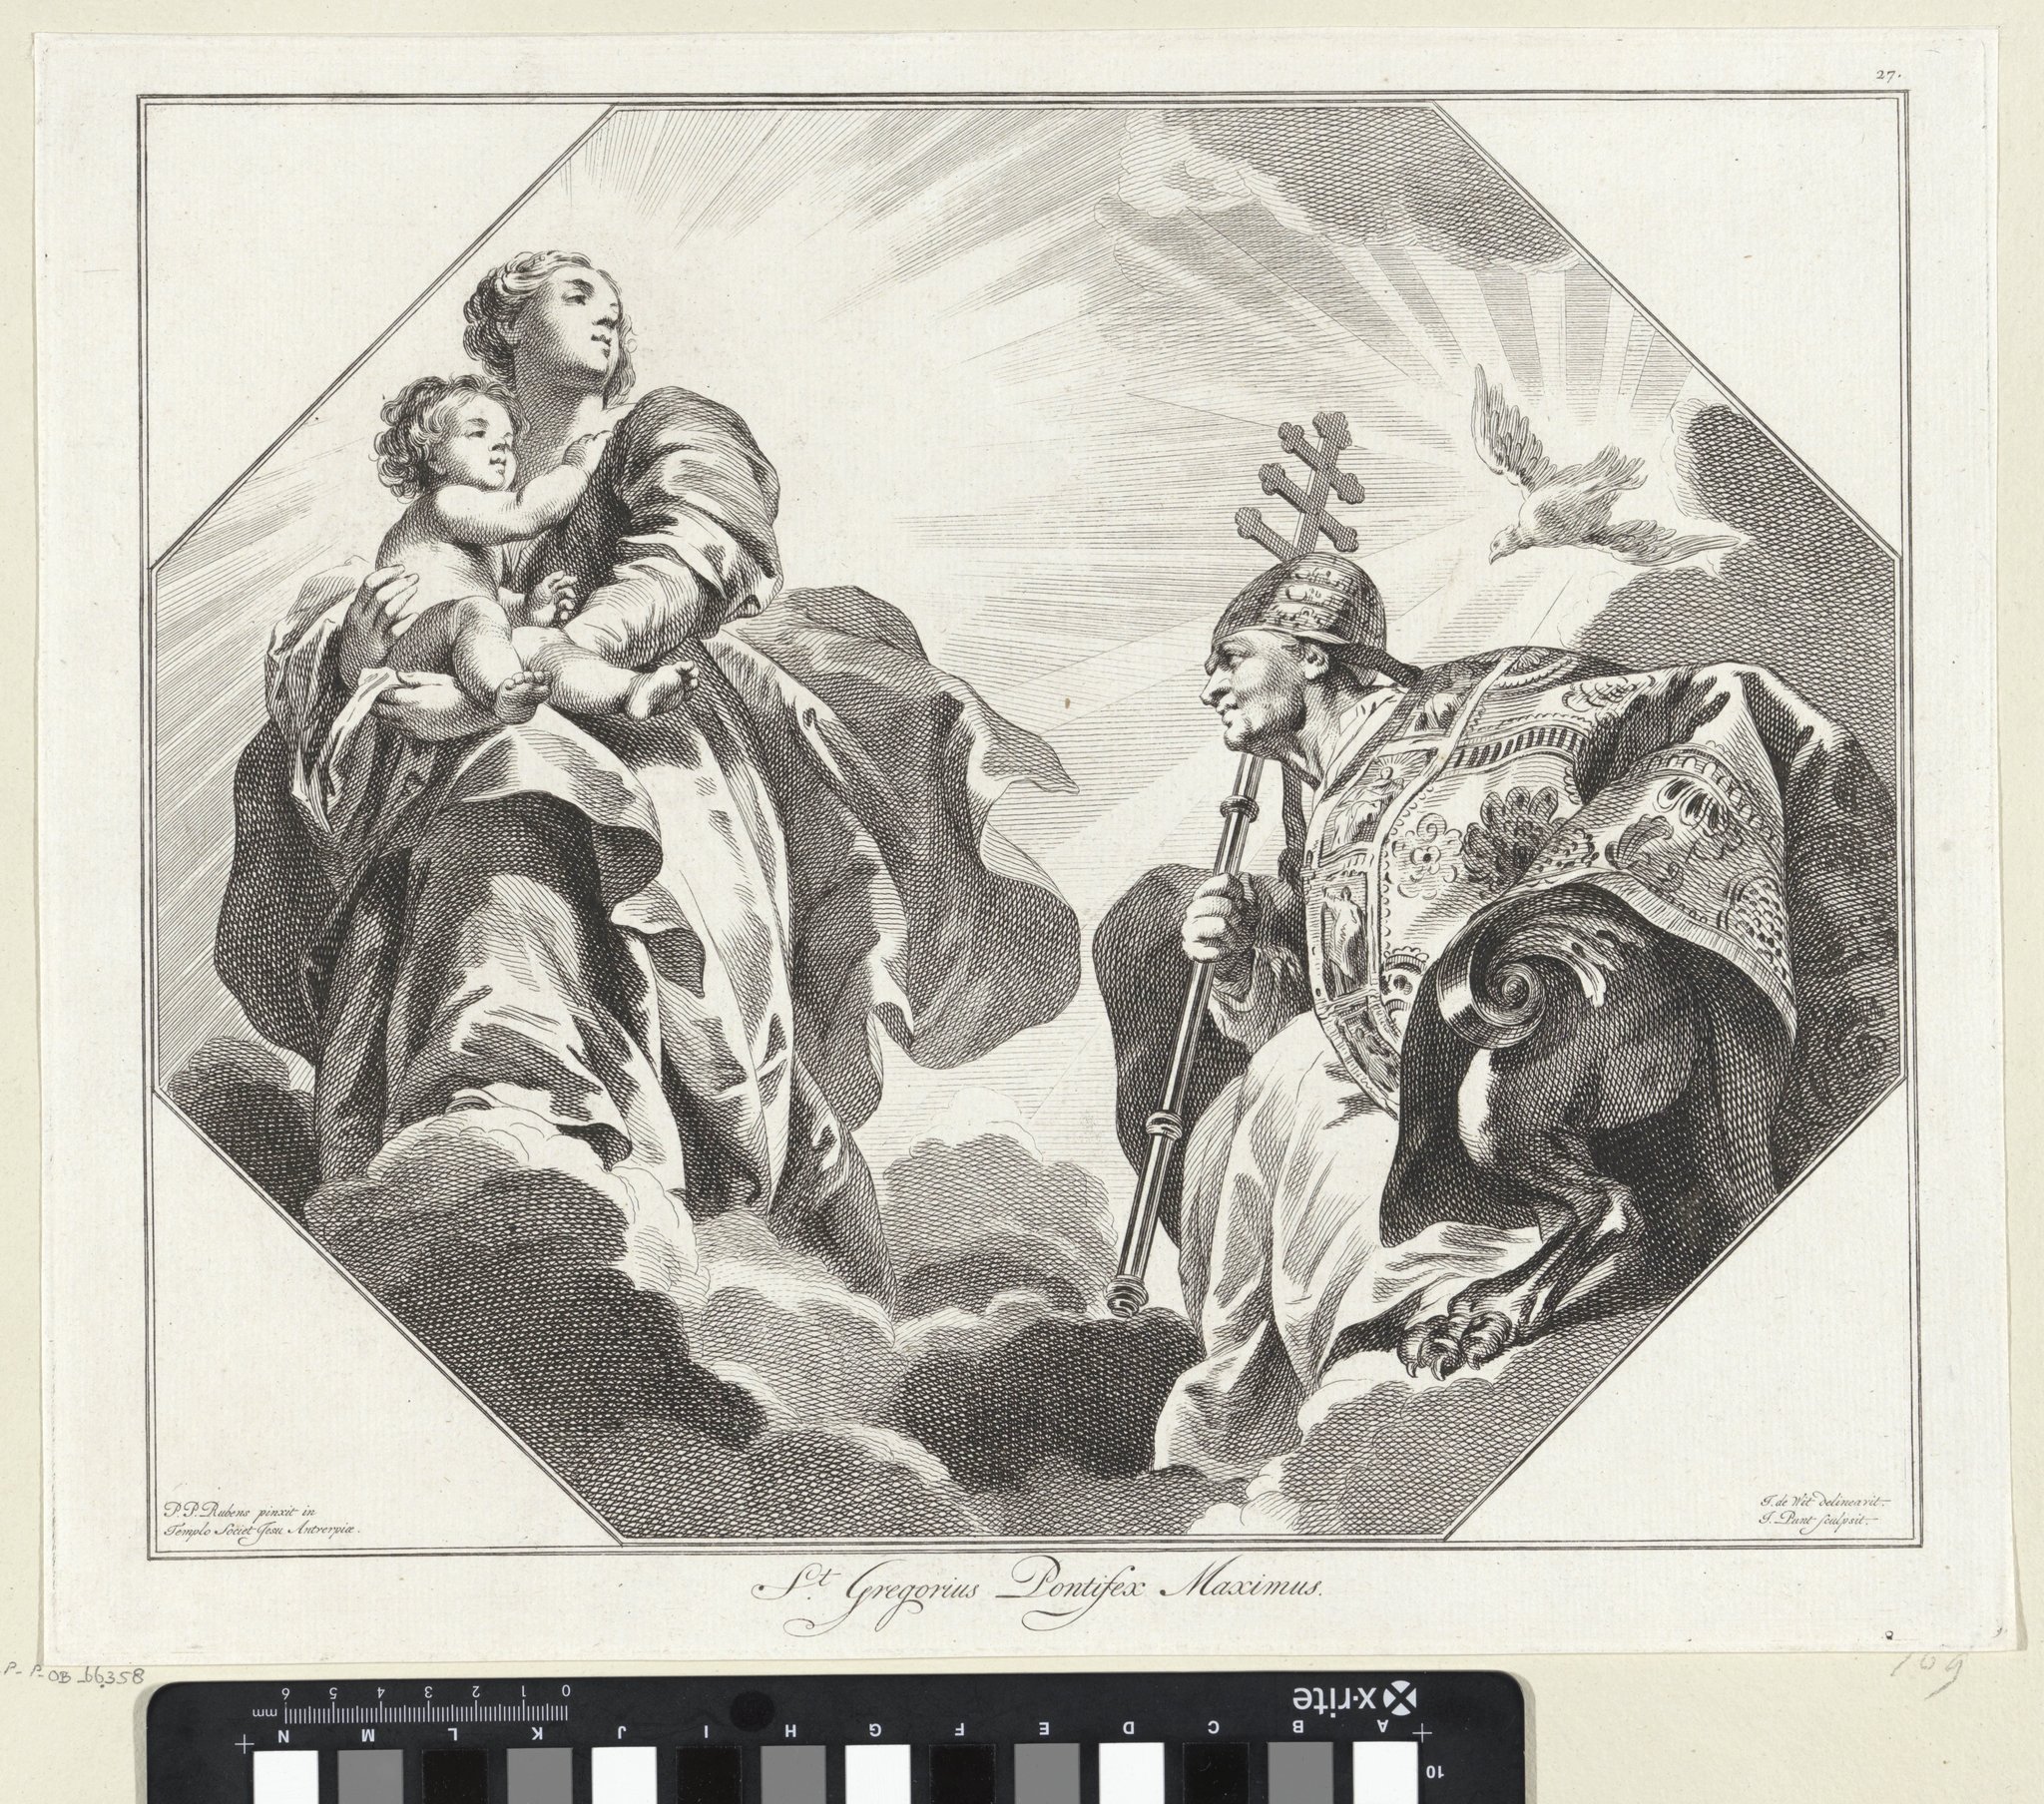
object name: print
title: Les plat-fonds ou les tableaux des galeries / De plafonds of gallerystukken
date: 1721-1779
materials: paper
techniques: engraving, etching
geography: amsterdam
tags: pope gregory the great; possible attributes: dove, emperor trajan (+ mary)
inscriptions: collector's mark: Lugt 240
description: Paus Gregorius en Maria met kind; onder de octagonale voorstelling een vers in het Latijn.